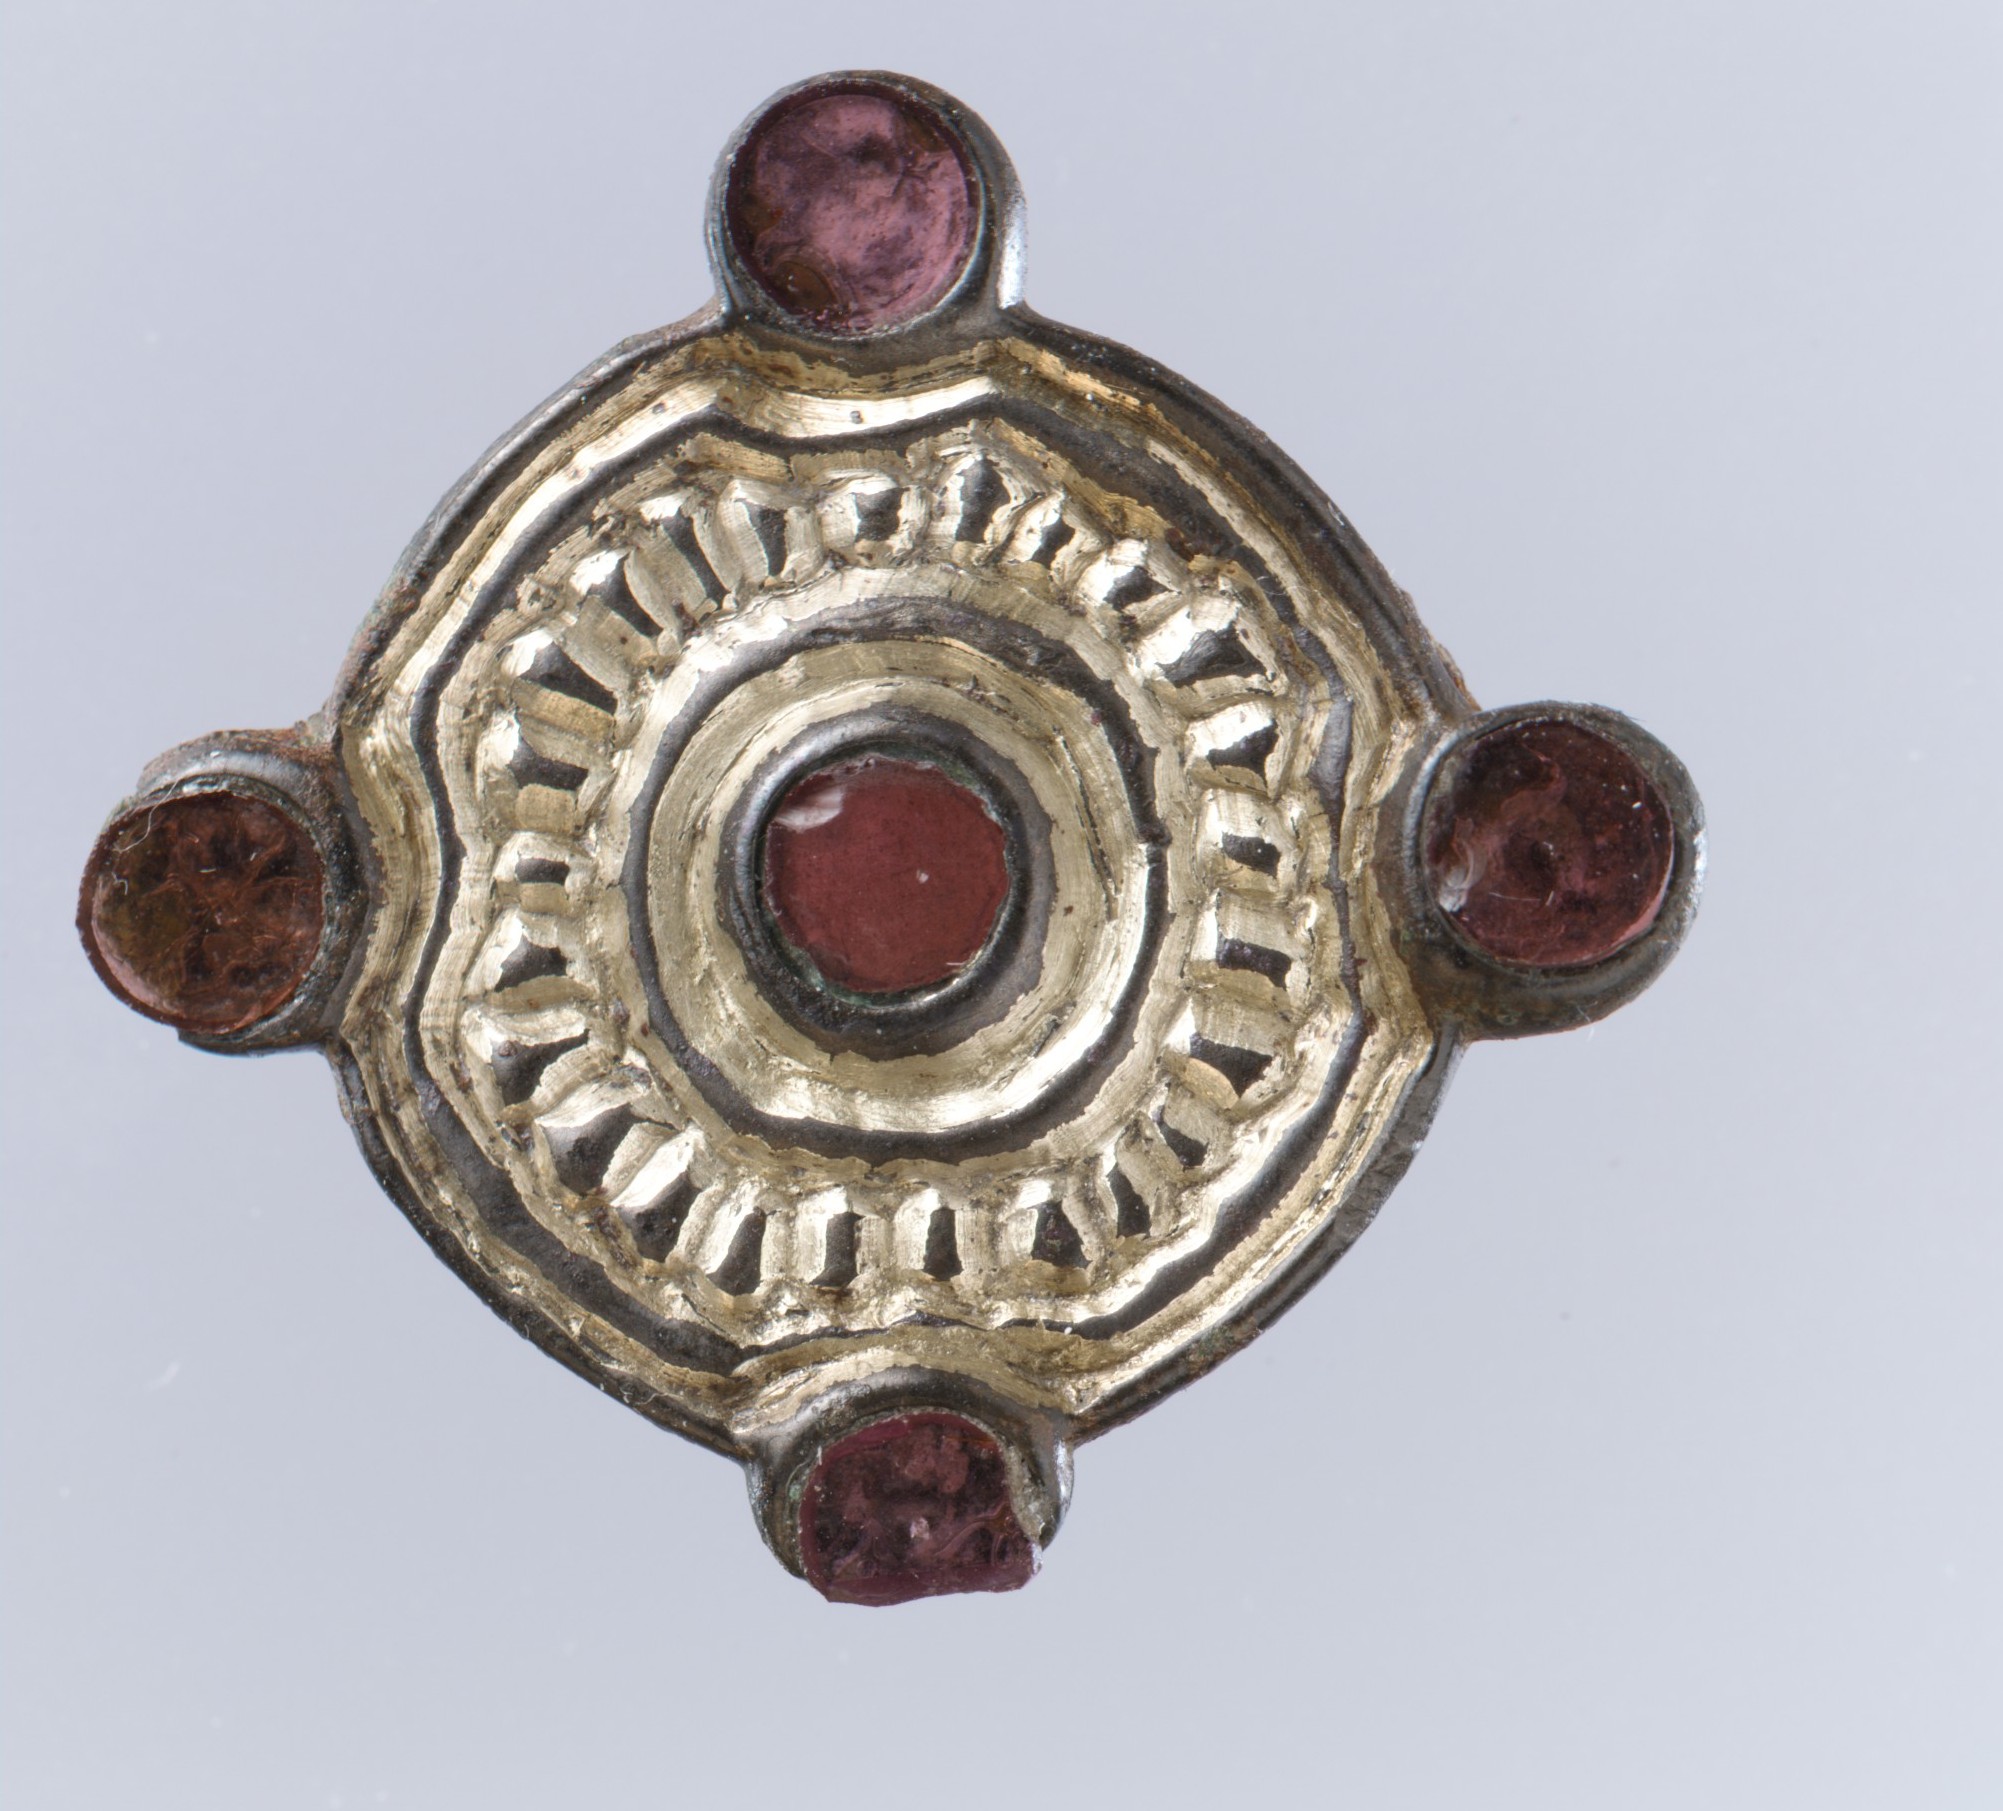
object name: brooch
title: Whorl-Shaped Brooch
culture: frankish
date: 550-650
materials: glass, iron, paste, silver gilt